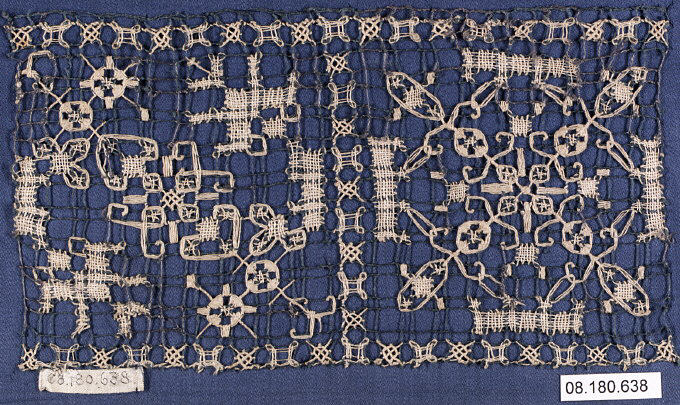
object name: network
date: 1601-1700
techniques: embroidery